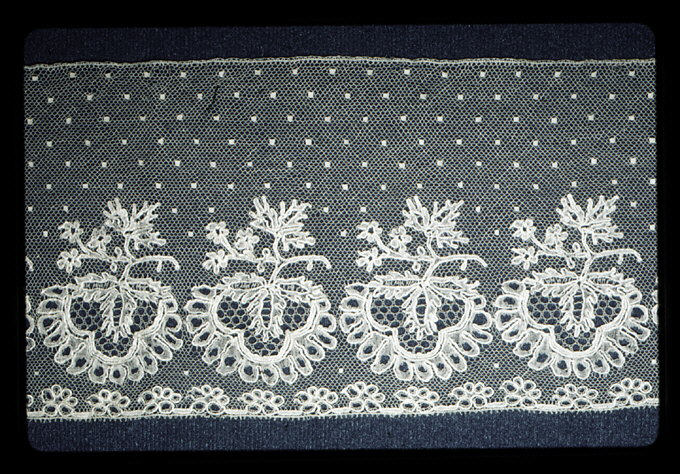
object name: fragment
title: Fragment of lace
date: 1801-1900